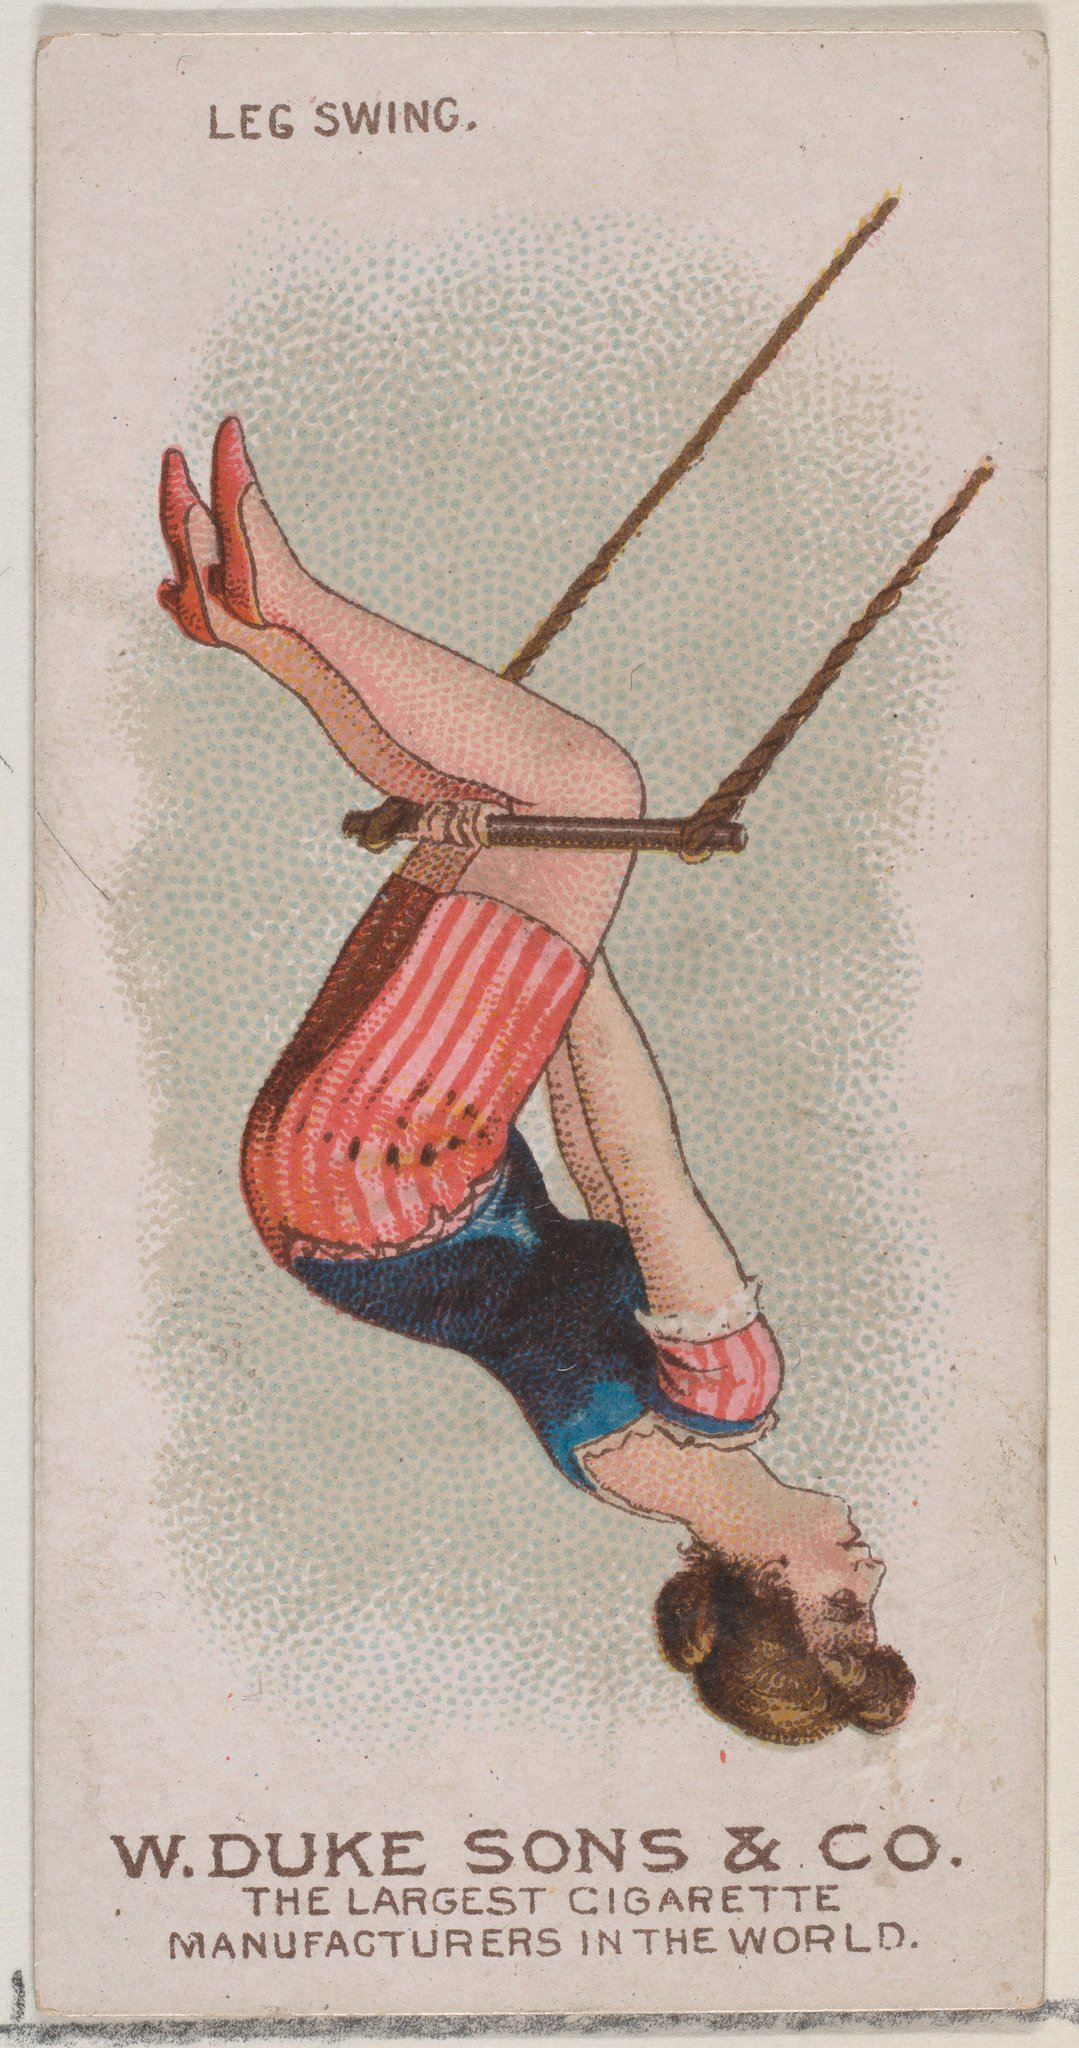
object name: print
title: Leg Swing, from the Gymnastic Exercises series (N77) for Duke brand cigarettes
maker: w. duke, sons & co.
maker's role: publisher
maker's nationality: american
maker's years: 1870-1920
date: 1887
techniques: color lithograph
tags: women,sports,athletes